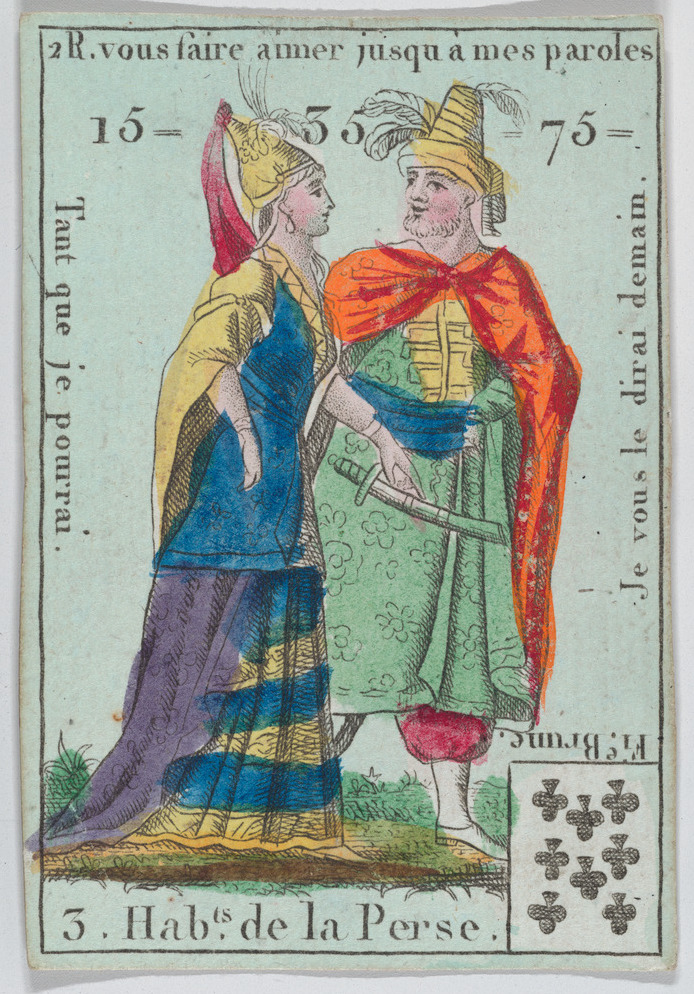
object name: print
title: Hab.ts de la Perse from Playing cards "Jeu d'Or"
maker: anonymous, french, 18th century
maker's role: artist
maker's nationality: french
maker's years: 1700-1800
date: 1700-1799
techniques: etching, hand coloring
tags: men,portraits,profiles,women,playing cards